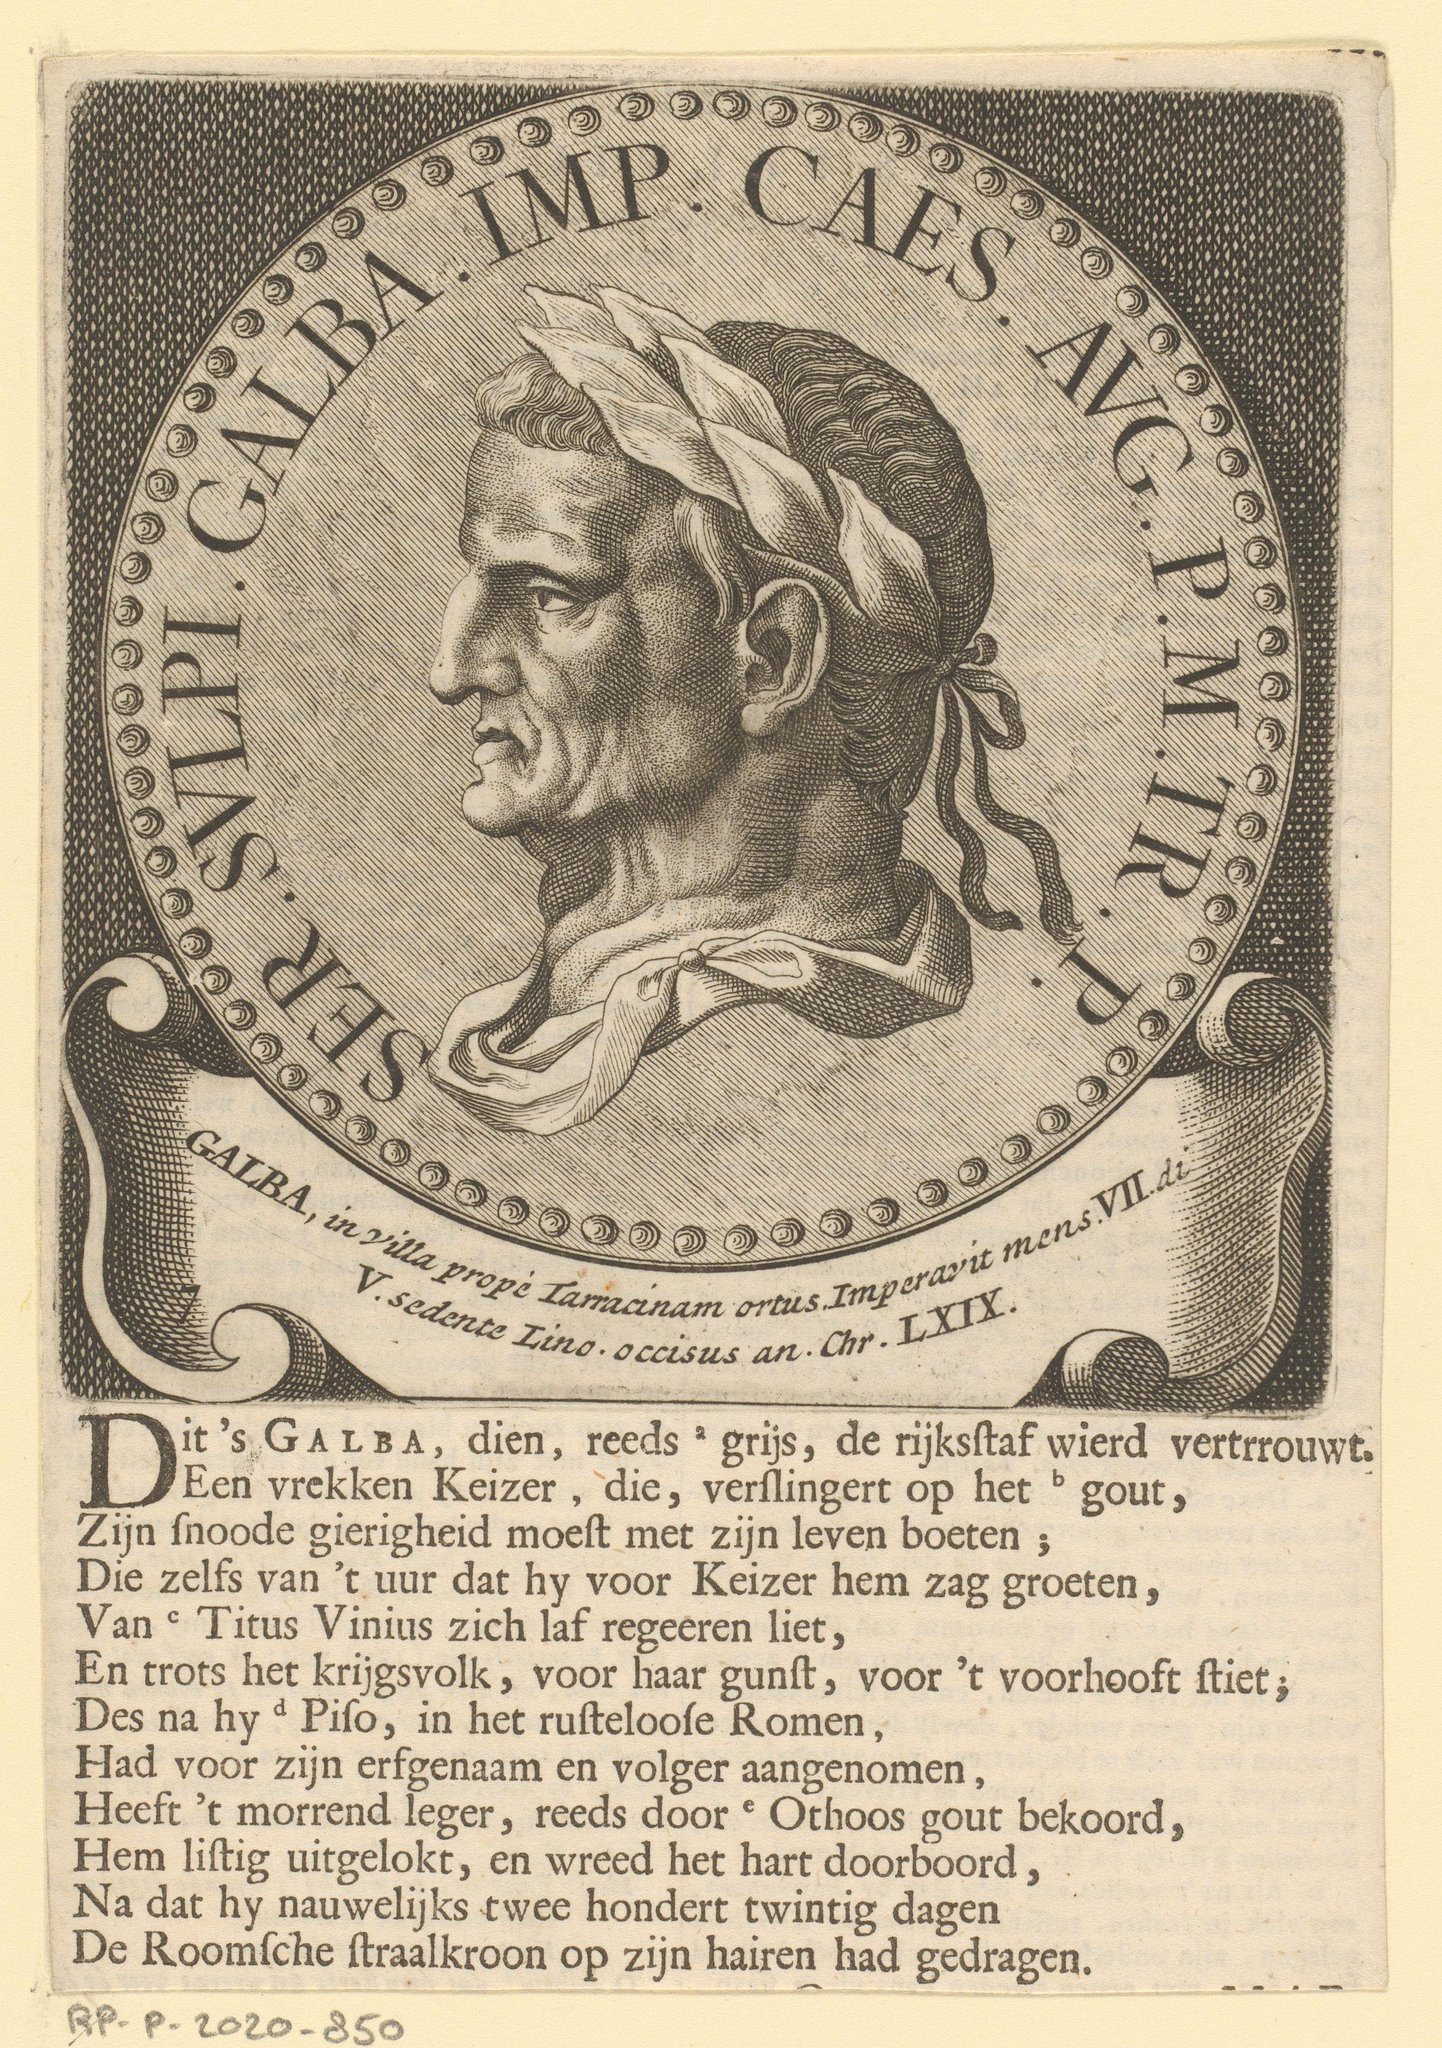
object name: print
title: Galba, in villa prope Tarracinam ortus (...)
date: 1697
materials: paper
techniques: engraving, etching, letterpress printing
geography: utrecht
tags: historical persons, emperor, male persons from classical history (galba)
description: Prent uit: Bogaert, Abraham. De Roomsche monarchy, vertoont in de muntbeelden der westersche en oostersche keizeren (...). Utrecht: François Halma en Willem van de Water, 1697, p. 121. Eerste staat verschenen in een grotere prent met twaalf portretten, gedateerd 1695.